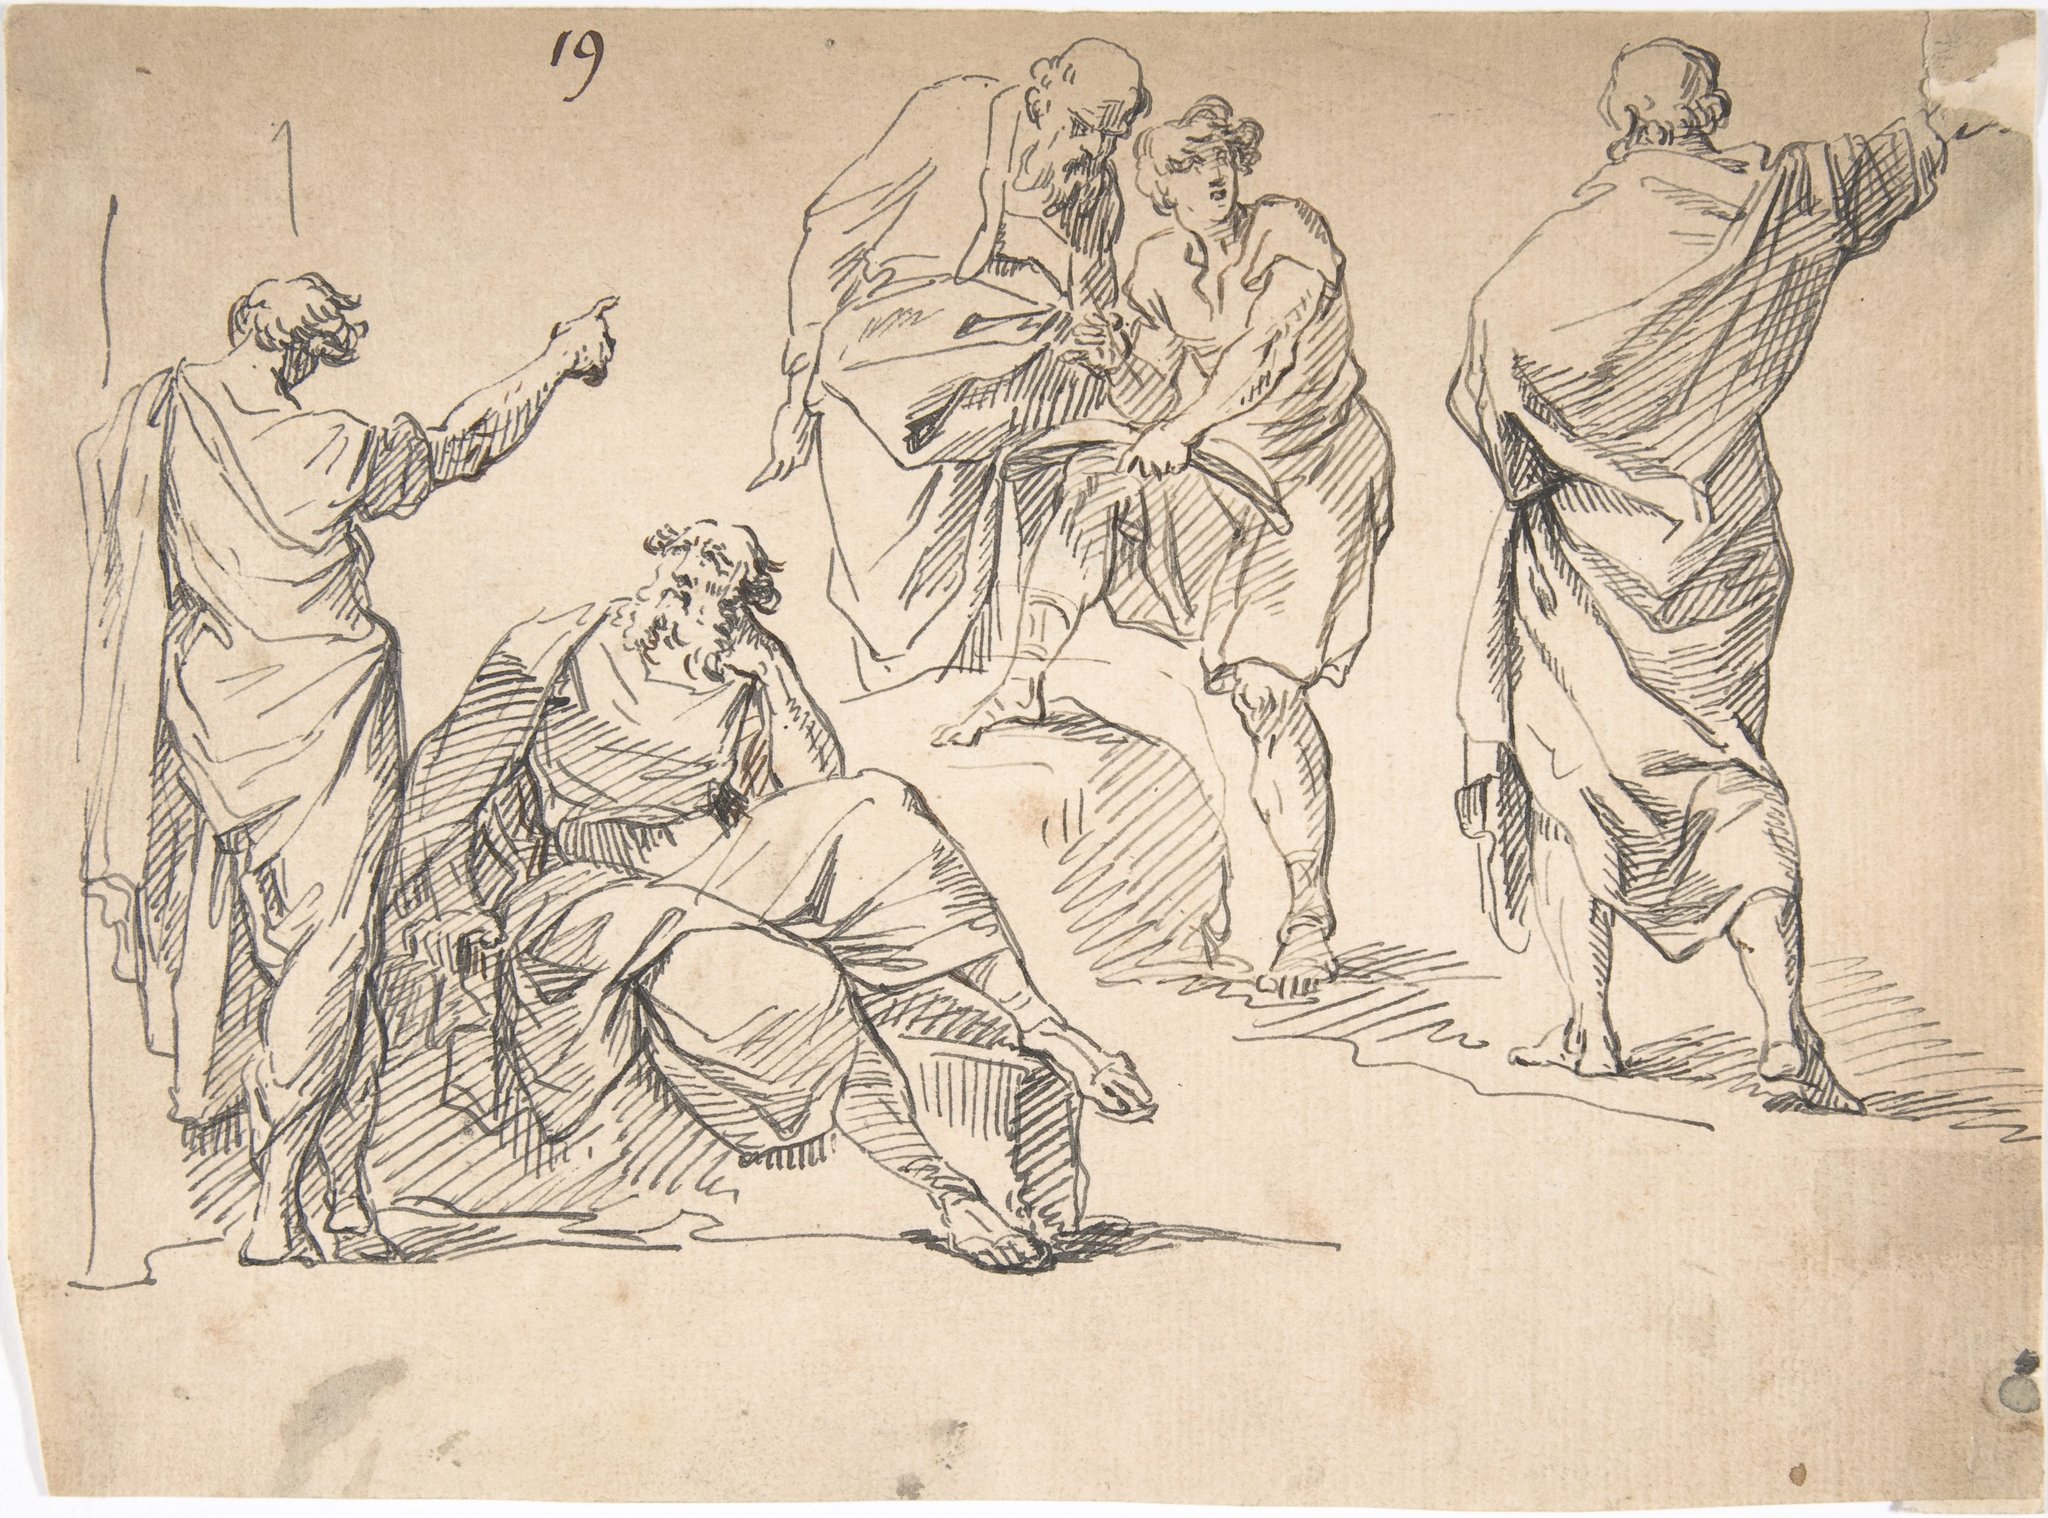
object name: drawing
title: Sheet of Male Figure Studies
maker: anonymous, french, 18th century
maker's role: artist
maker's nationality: french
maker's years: 1700-1800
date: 1701-1800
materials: ink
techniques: pen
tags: men